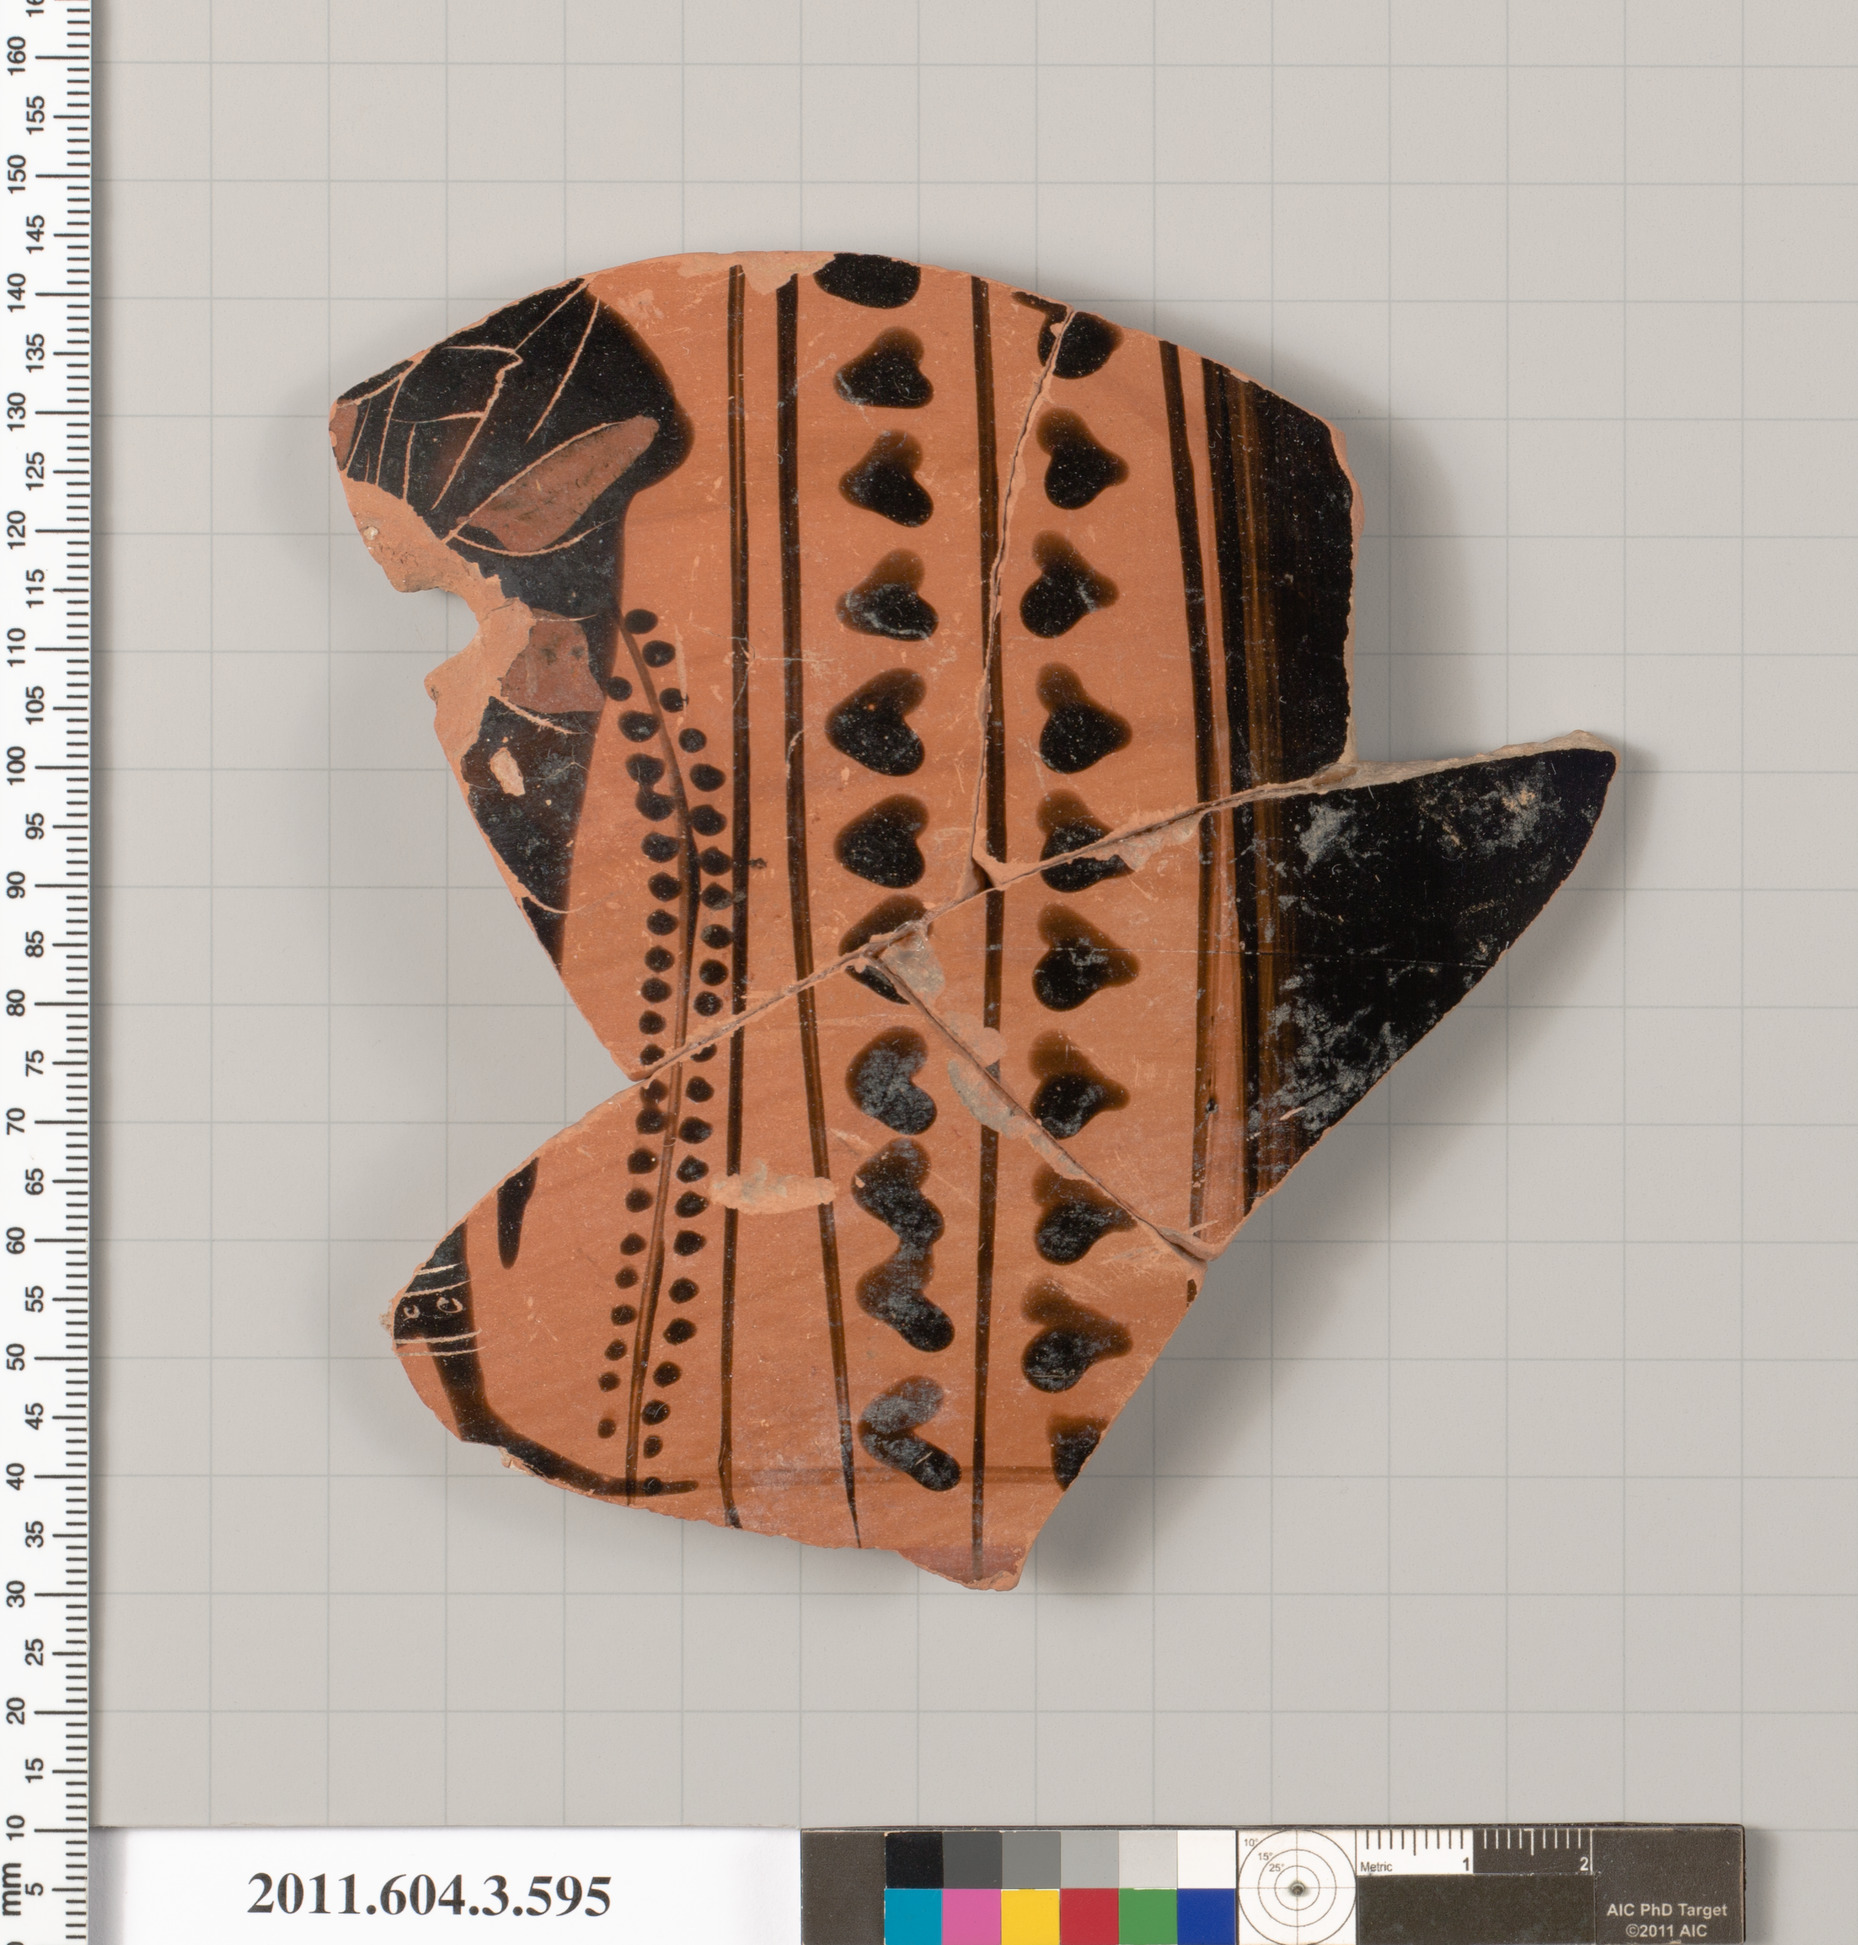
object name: column krater fragment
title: Terracotta fragment of a column-krater (bowl for mixing wine and water)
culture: greek, attic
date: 525-501 BCE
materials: terracotta